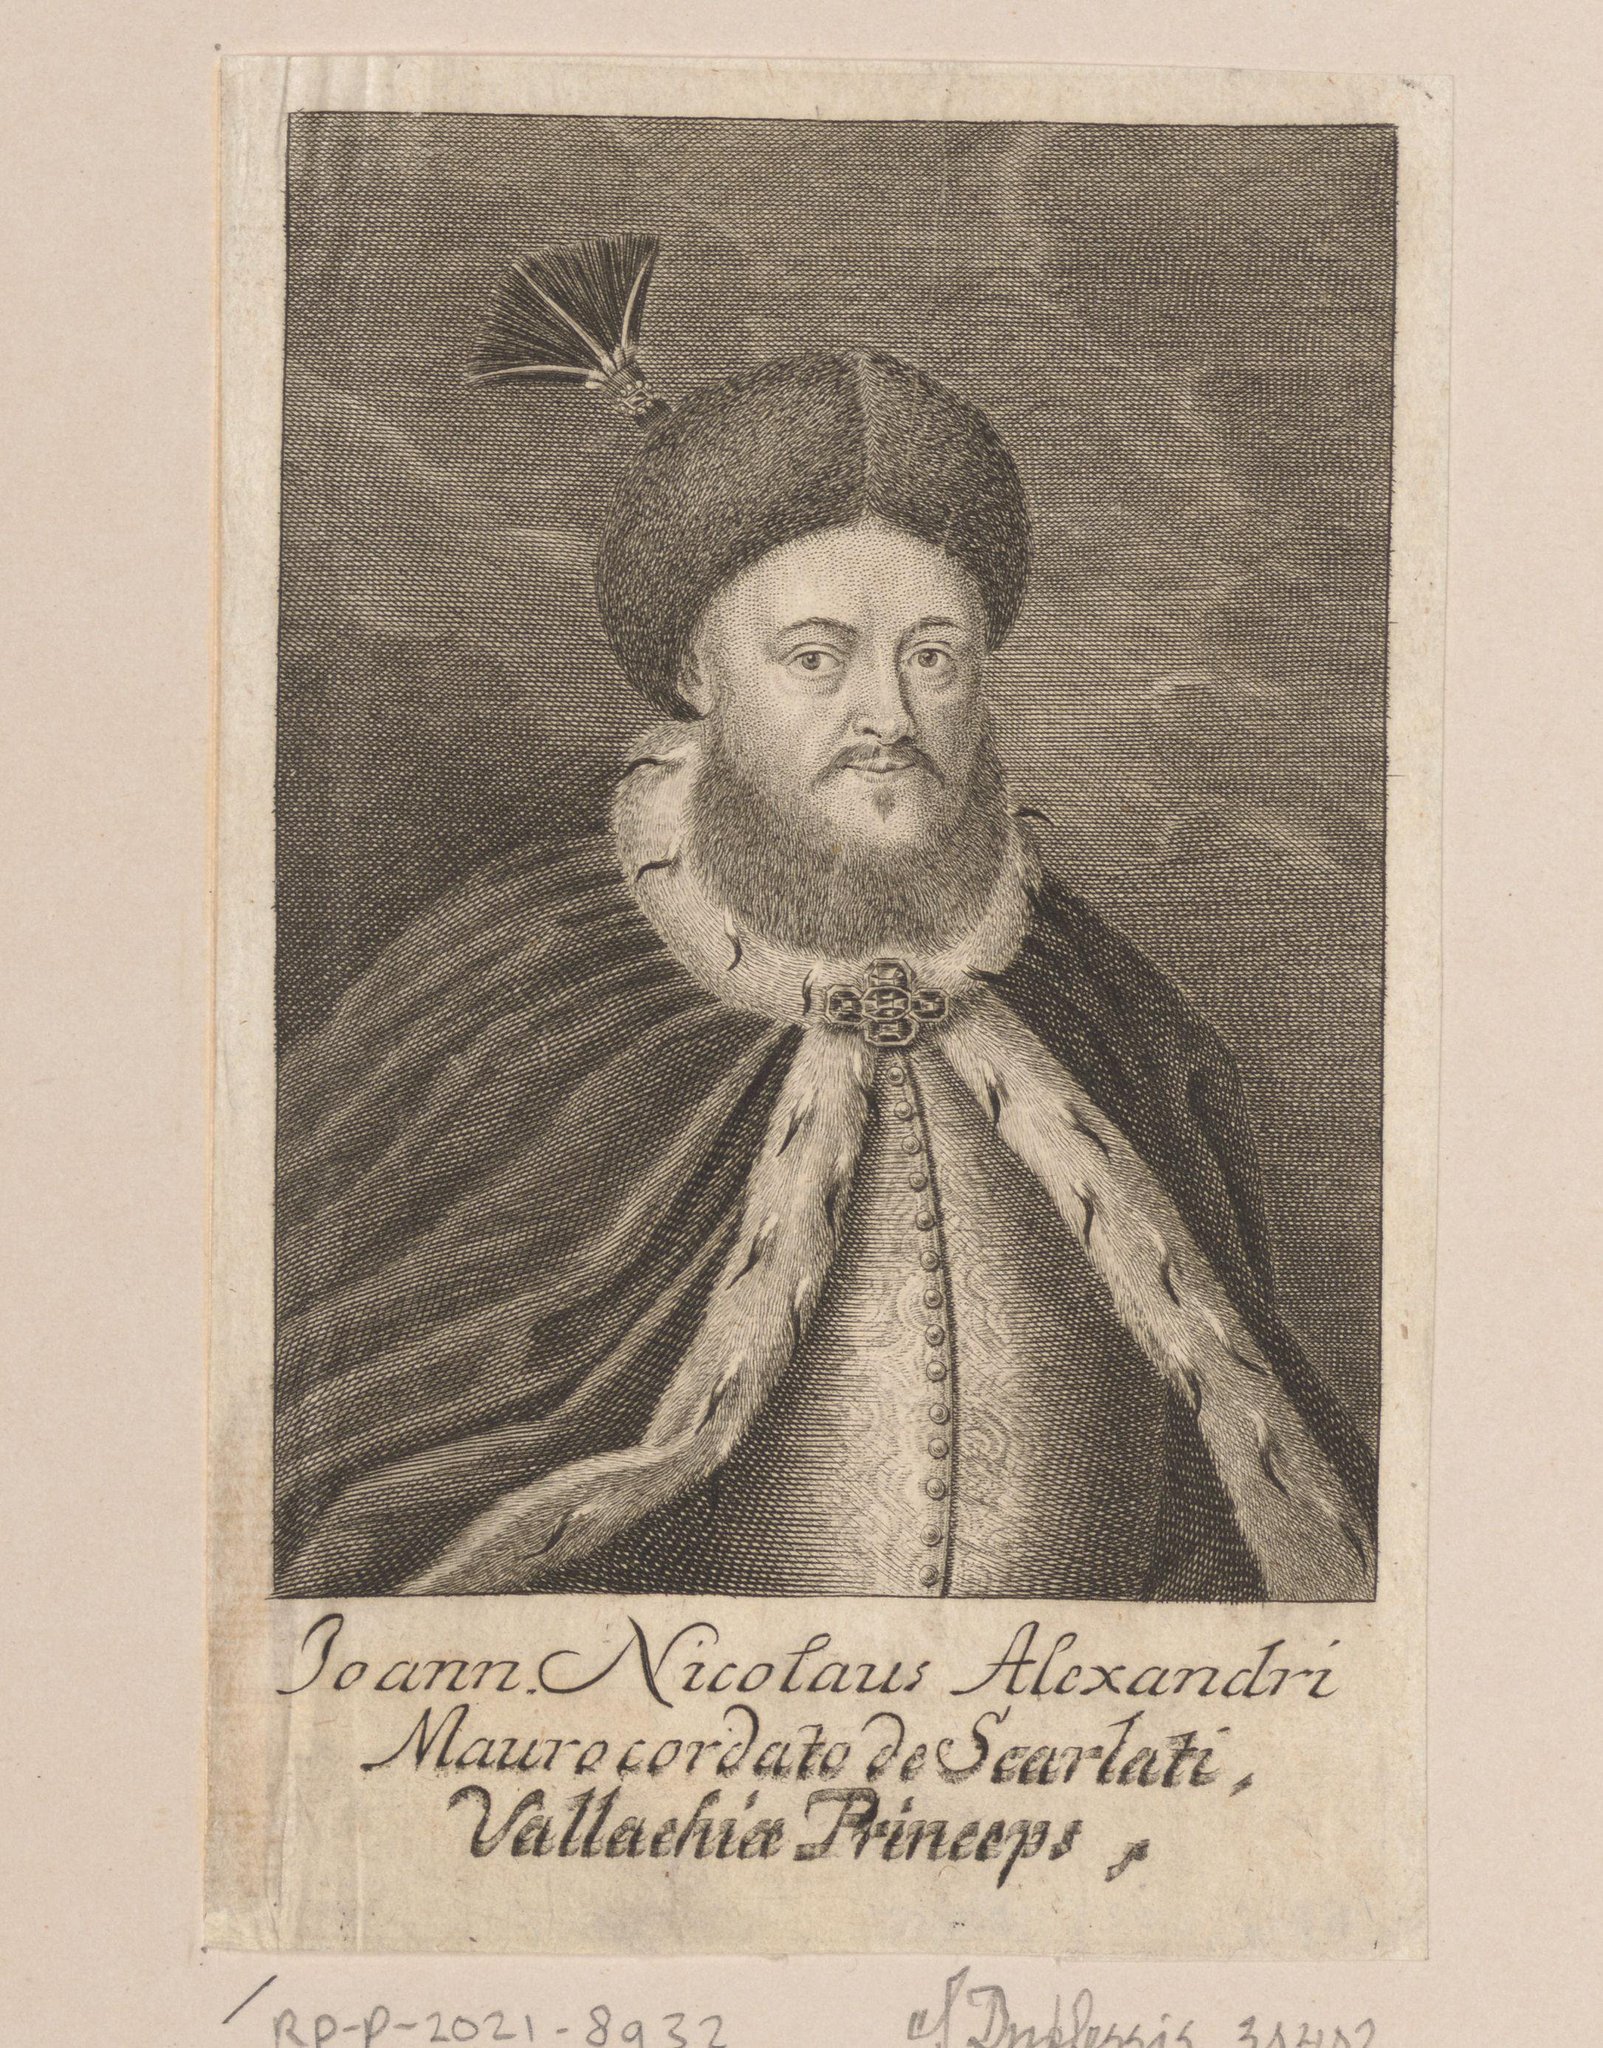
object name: print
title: Portret van Nikolaos Maurokordatos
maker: Anonymous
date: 1722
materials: paper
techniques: engraving, etching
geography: germany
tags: historical persons, crown prince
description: Prent waarschijnlijk uit: Die Europäische Fama, Welche den gegenwärtigen Zustand der vornehmsten Höfe entdecket (1723), dl. 262.